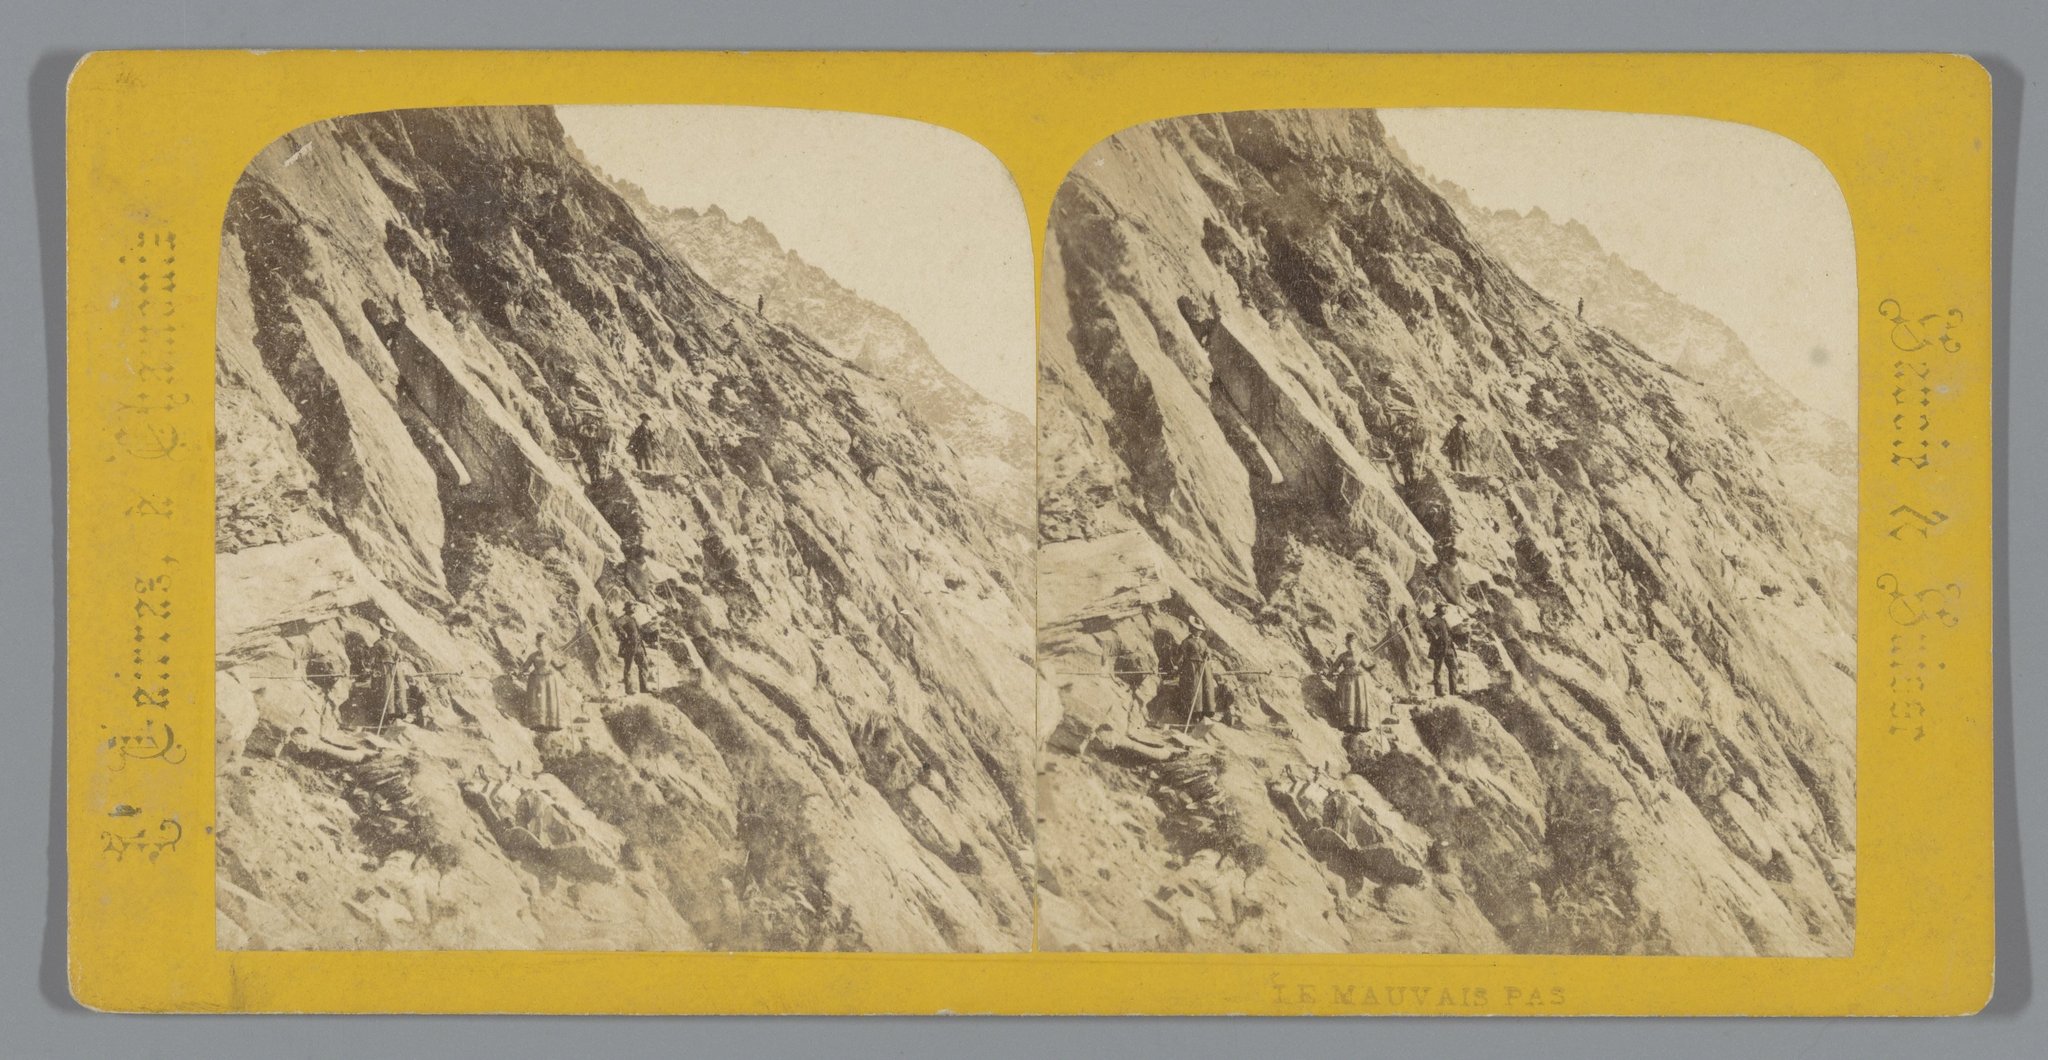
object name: stereograph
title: Bergbeklimmers langs een bergpas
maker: joseph tairraz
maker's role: fotograaf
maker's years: 1827-1902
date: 1860-1870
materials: cardboard, photographic support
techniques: albumen print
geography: haute-savoie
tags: climbing, mountains